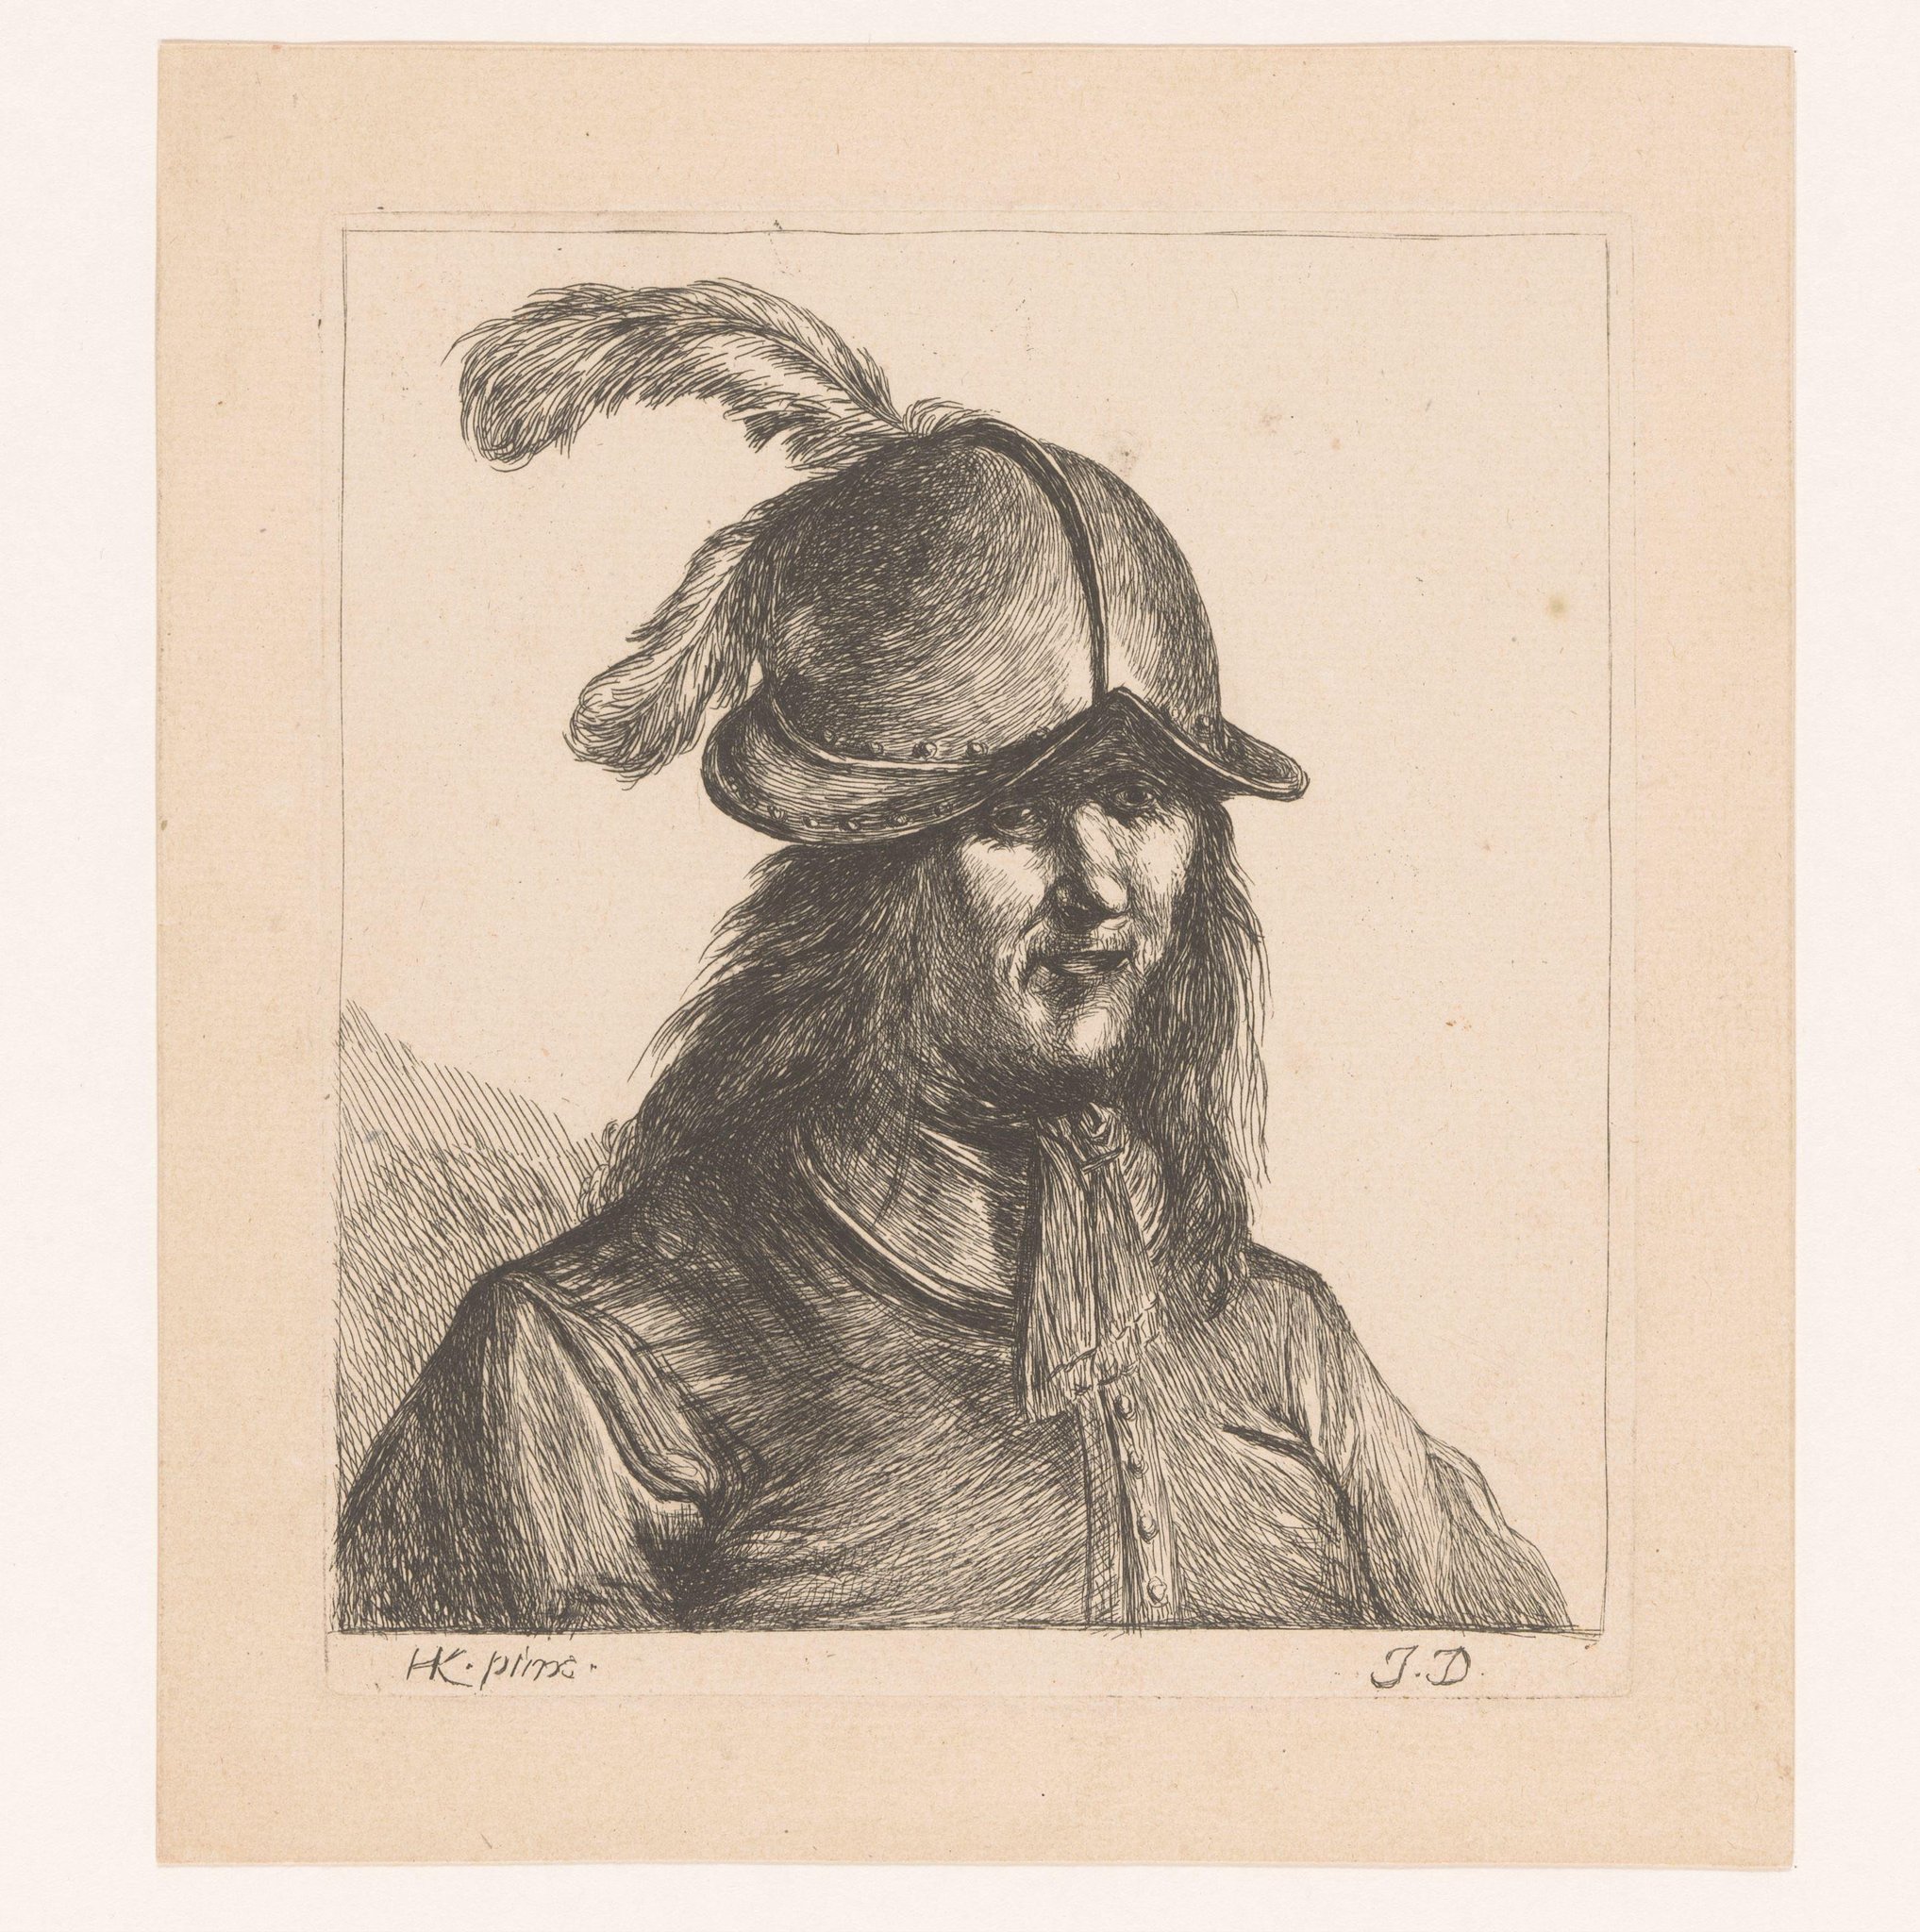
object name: print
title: Buste van soldaat met helm met veer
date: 1700-1799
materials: paper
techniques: etching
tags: the soldier; the soldier's life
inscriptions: collector's mark: Lugt 240